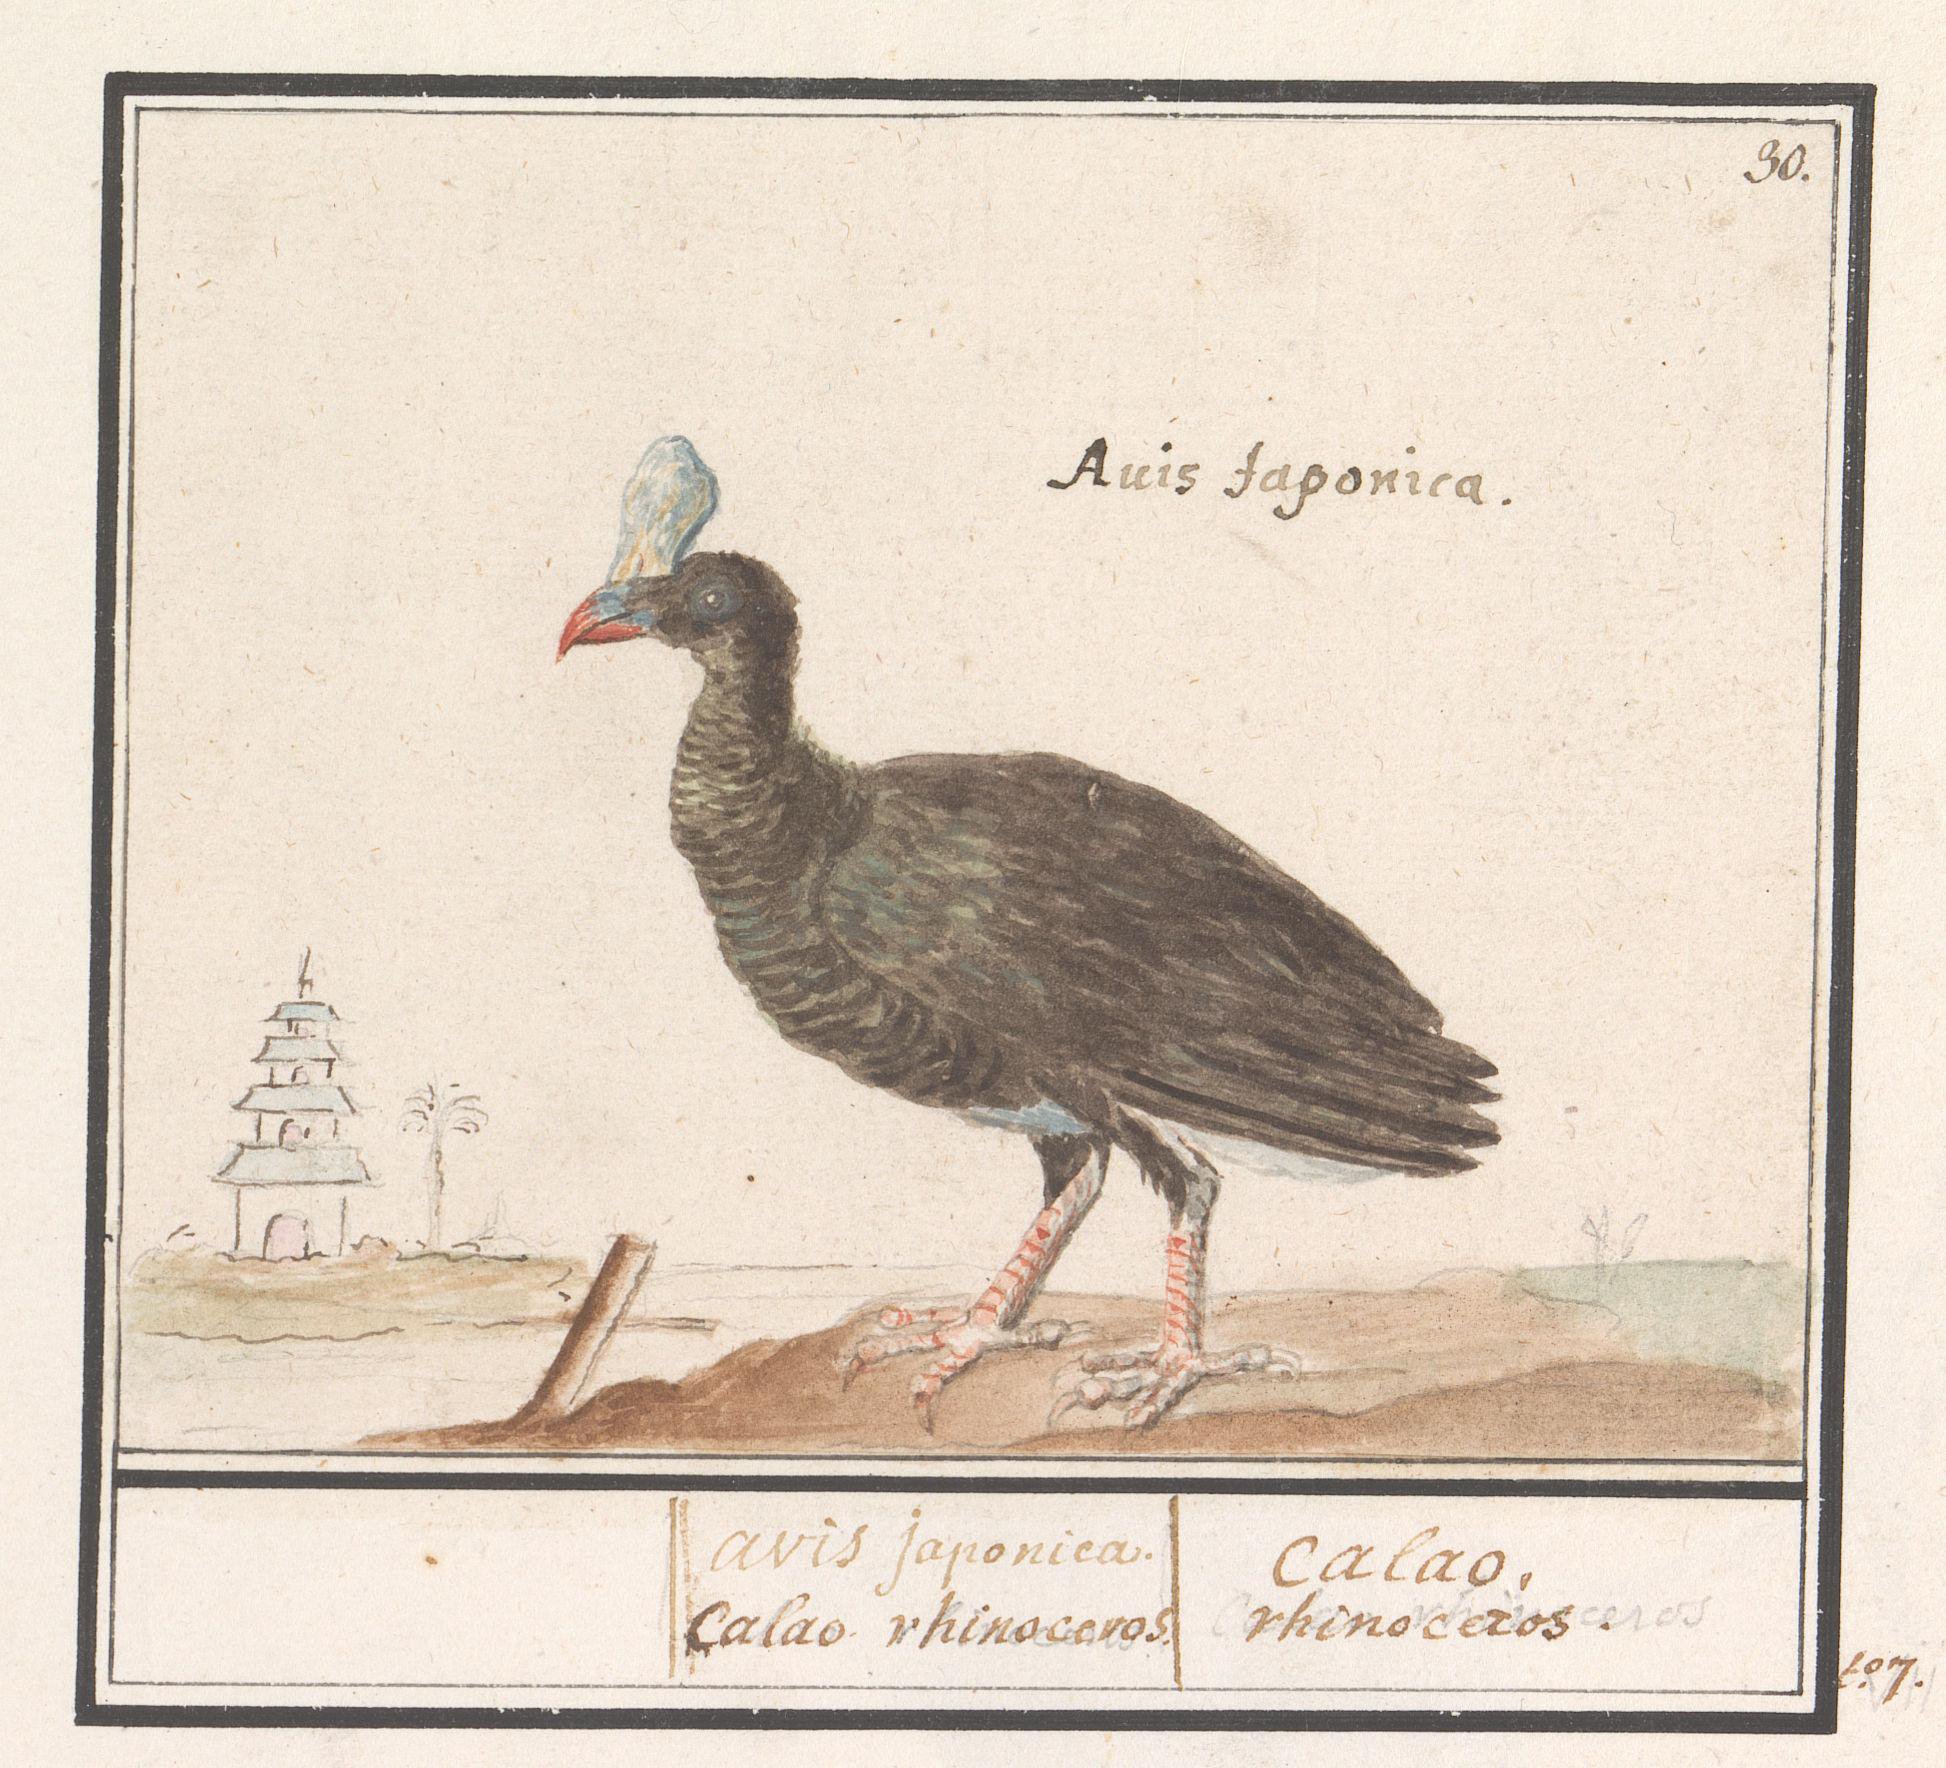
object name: drawing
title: Helmhokko (Crax pauxi / Pauxi pauxi)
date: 1596-1610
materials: chalk, paint, ink, paper, pencil, watercolor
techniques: brush, pen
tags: 25f39(helmeted curassow)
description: Helmhokko. Genummerd rechtsboven: 30. Met een (verkeerde) Latijnse naam. Onderdeel van het derde album met tekeningen van vogels. Vijfde van twaalf albums met tekeningen van dieren, vogels en planten bekend rond 1600, gemaakt in opdracht van keizer Rudolf II. Met toelichting in Nederlands, Latijn en Frans.